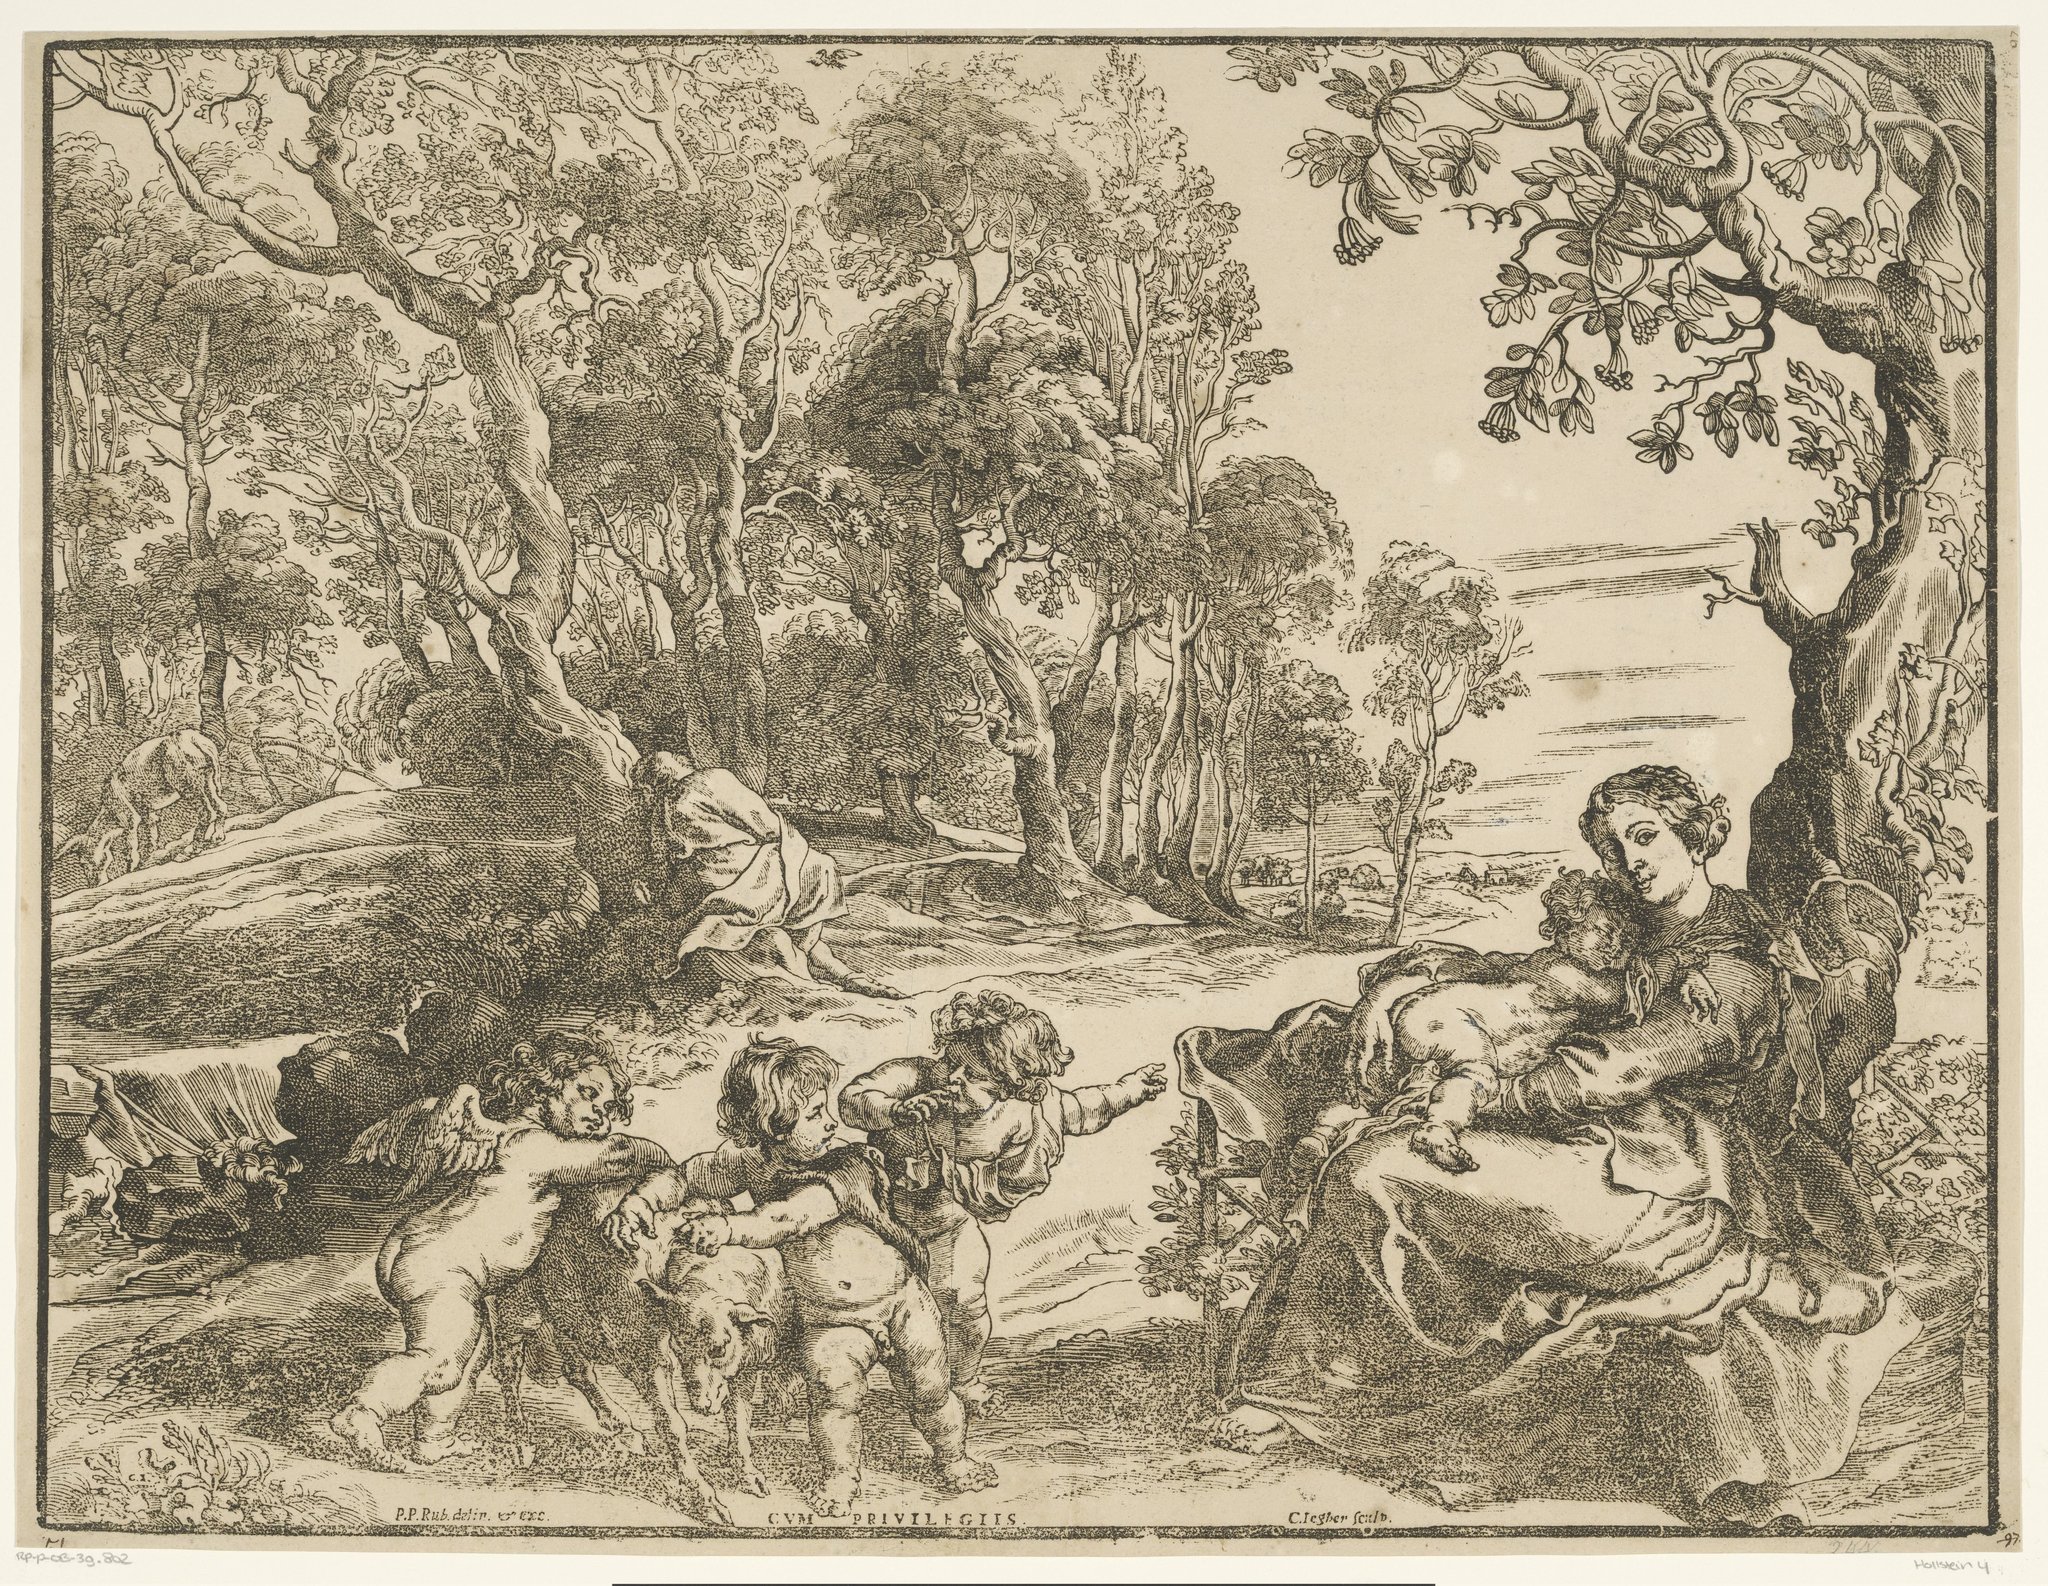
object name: print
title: Rest on the Flight into Egypt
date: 1606-1640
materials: paper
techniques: woodcut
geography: southern netherlands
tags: holy family with john the baptist (as child), rest on the flight into egypt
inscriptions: collector's mark: Lugt 240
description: Onder een boom rust Maria met het Christuskind in haar armen. Op de achtergrond ligt Jozef tegen een boom en graast de ezel in het gras. Op de voorgrond spelen Johannes de Doper en twee engelen met een lam. Een van de engelen maant Johannes met een handgebaar tot stilte en wijst naar het slapende Kind.